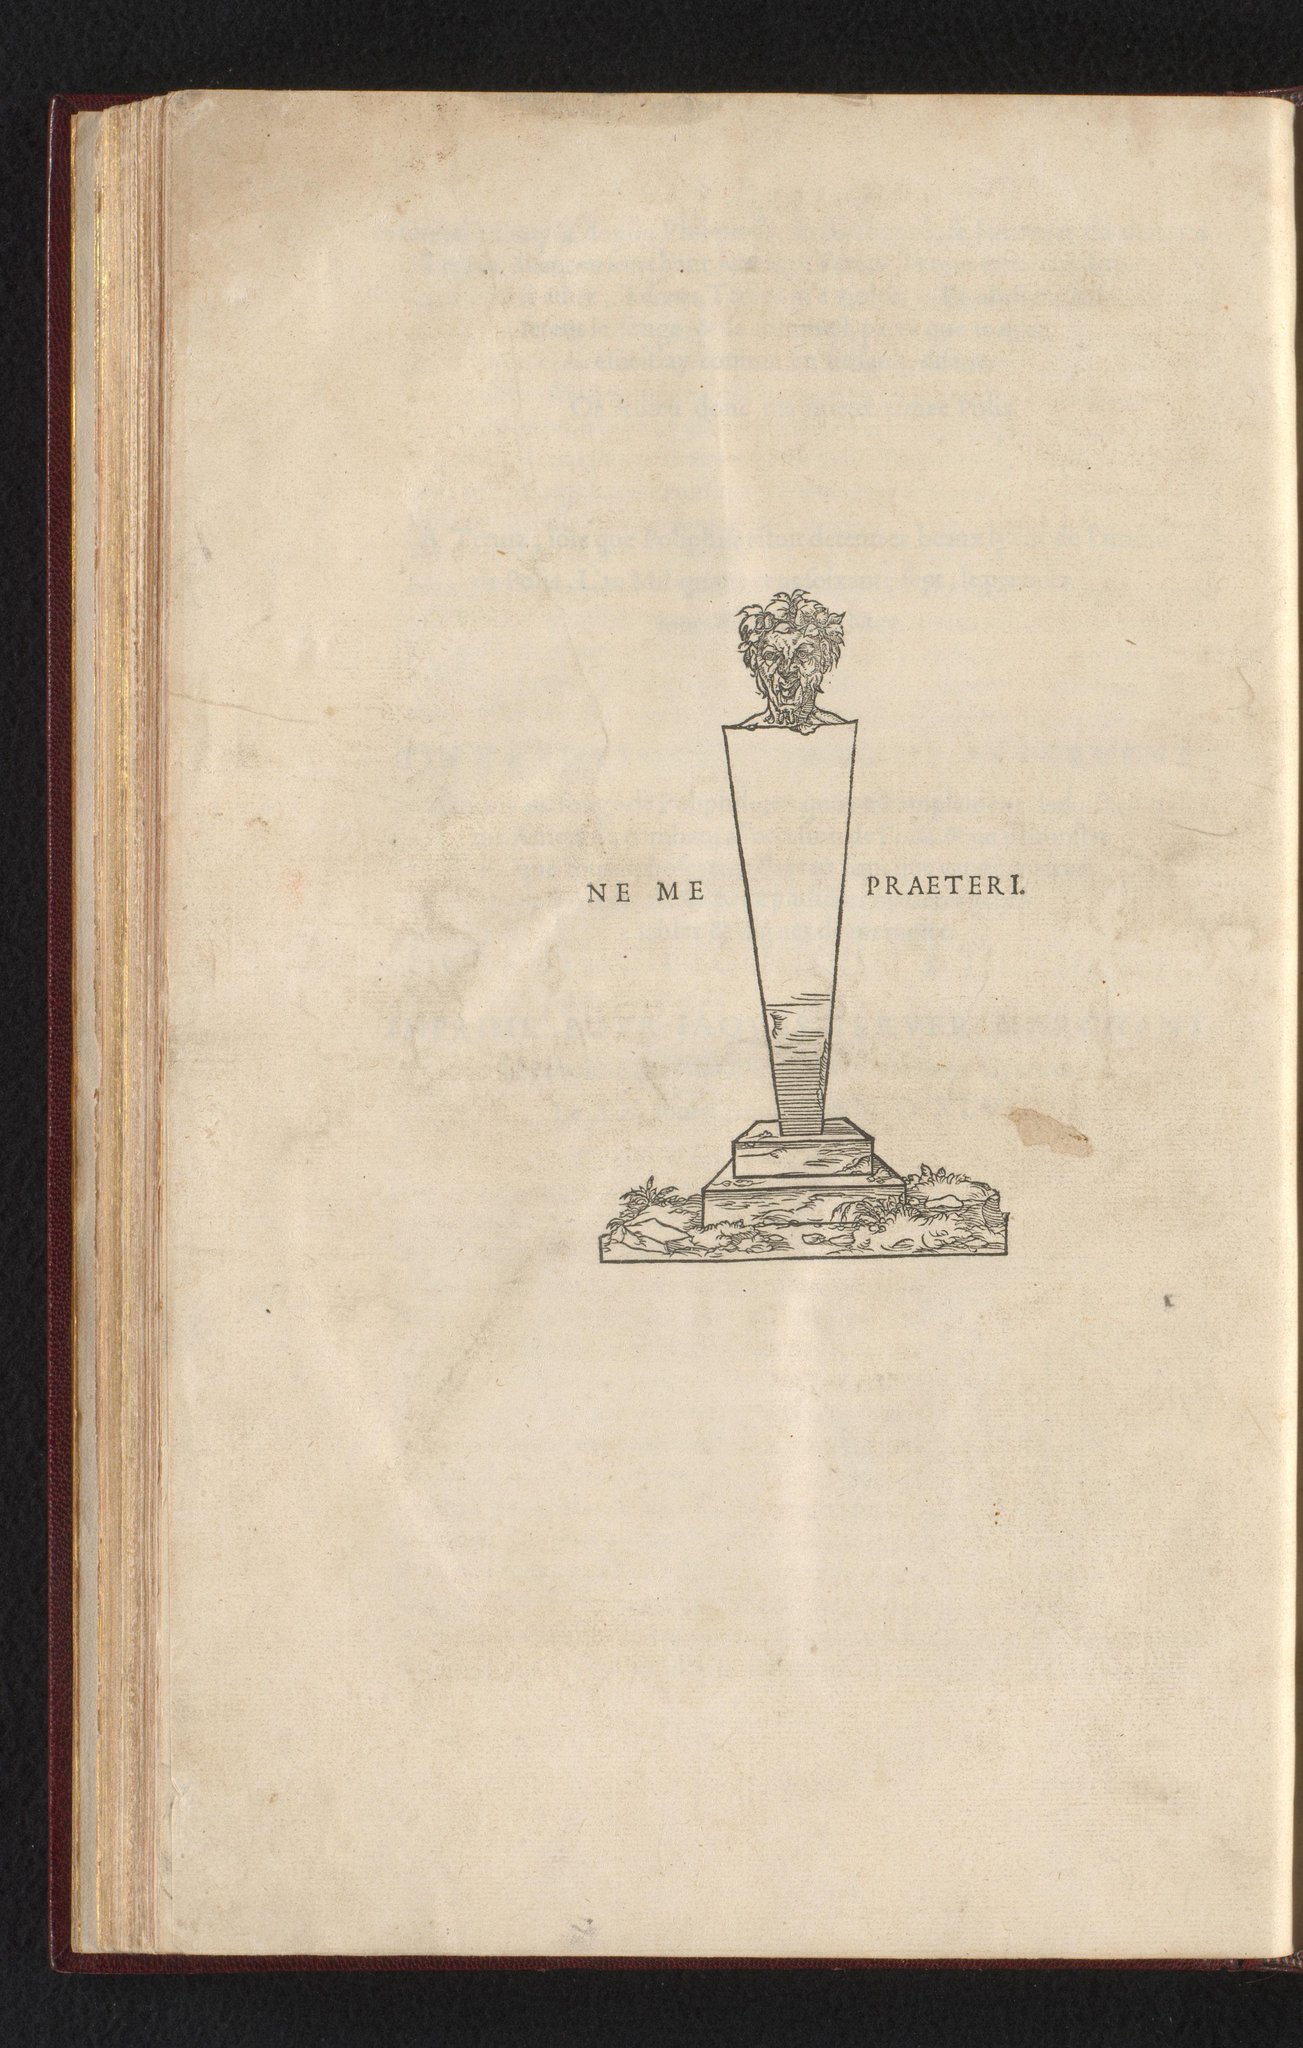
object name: print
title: Sokkel met kop van een satyr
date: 1546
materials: paper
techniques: woodcut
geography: paris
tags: (scenes from) specific works of literature: colonna, hypnerotomachia poliphili, satyr(s) (in general), monument, statue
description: Prent uit: Colonna, Francesco. Hypnerotomachie ou discours du songe de Poliphile, deduisant comme amour le combat a l'occasion de Polia. Parijs: Jacques Kerver, 1546, na colofon.